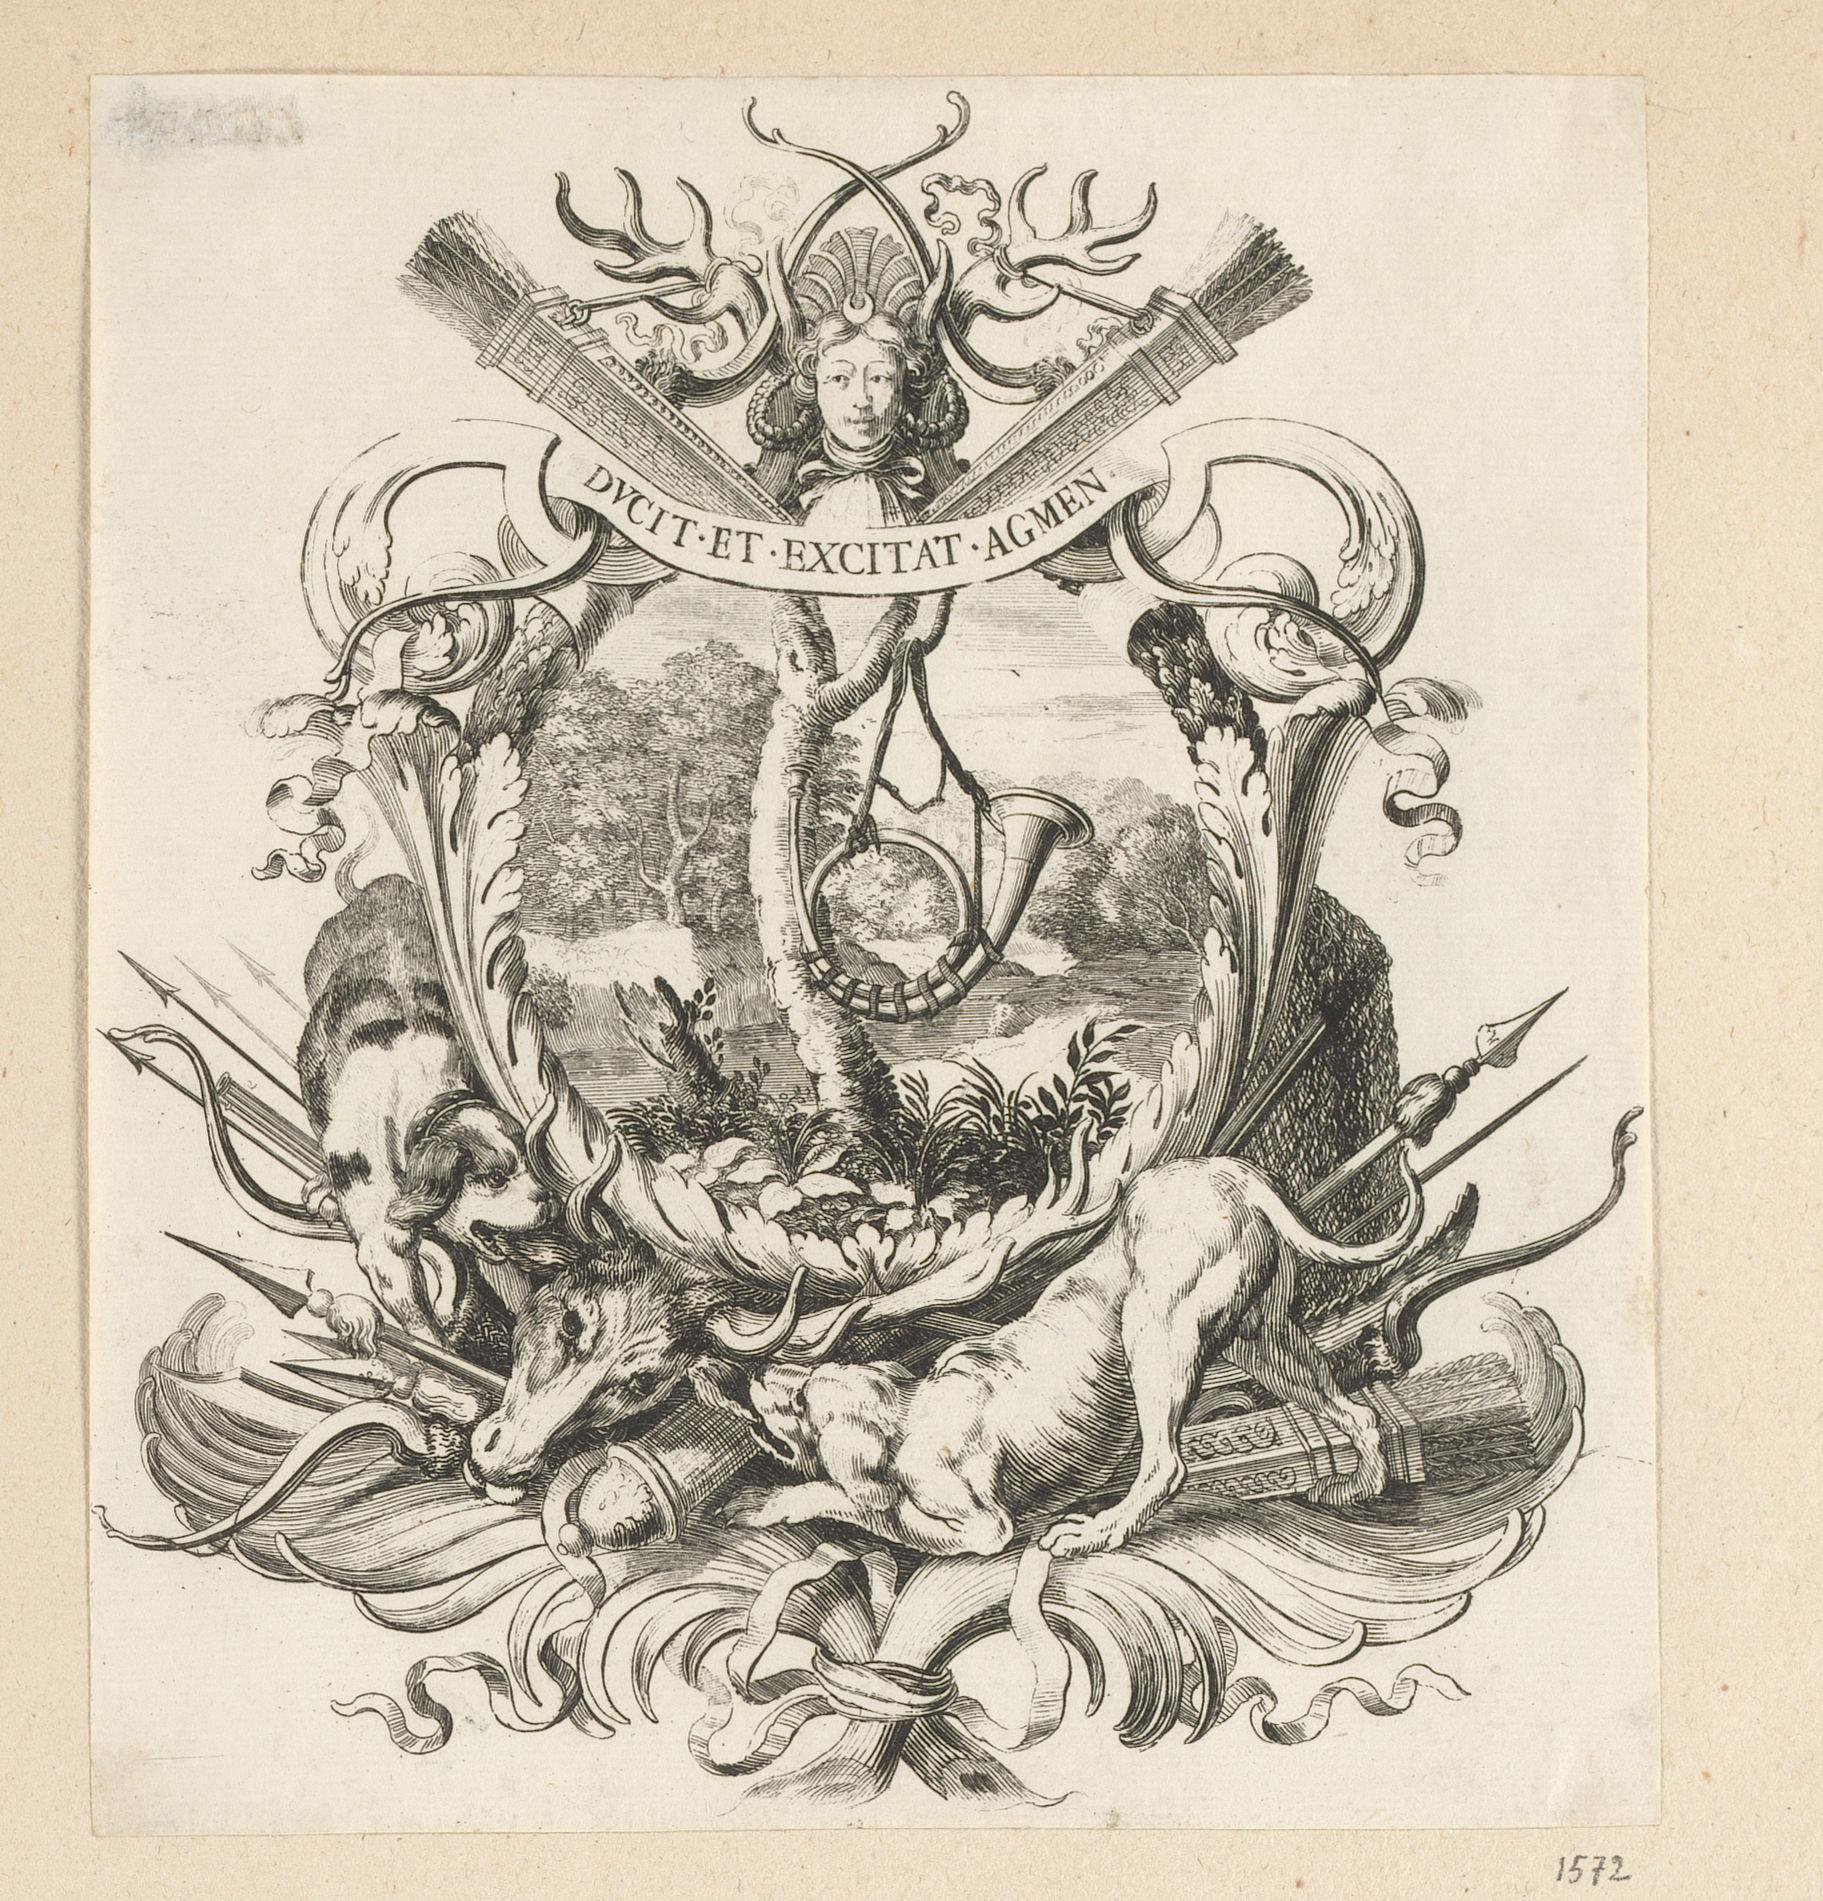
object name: album leaf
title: Ducit et excitat agmen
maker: sébastien leclerc (i)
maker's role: print maker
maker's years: 1637-1714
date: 1670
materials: paper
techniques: etching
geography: paris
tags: (story of) diana (artemis), hunting dogs, hunting horn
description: Prent gebruikt voor: Félibien, André. Devises pour les tapisseries du Roy, où sont représentez les quatre éléments et les quatre saisons de l'année (...). Parijs: Imprimerie Royale, 1670.